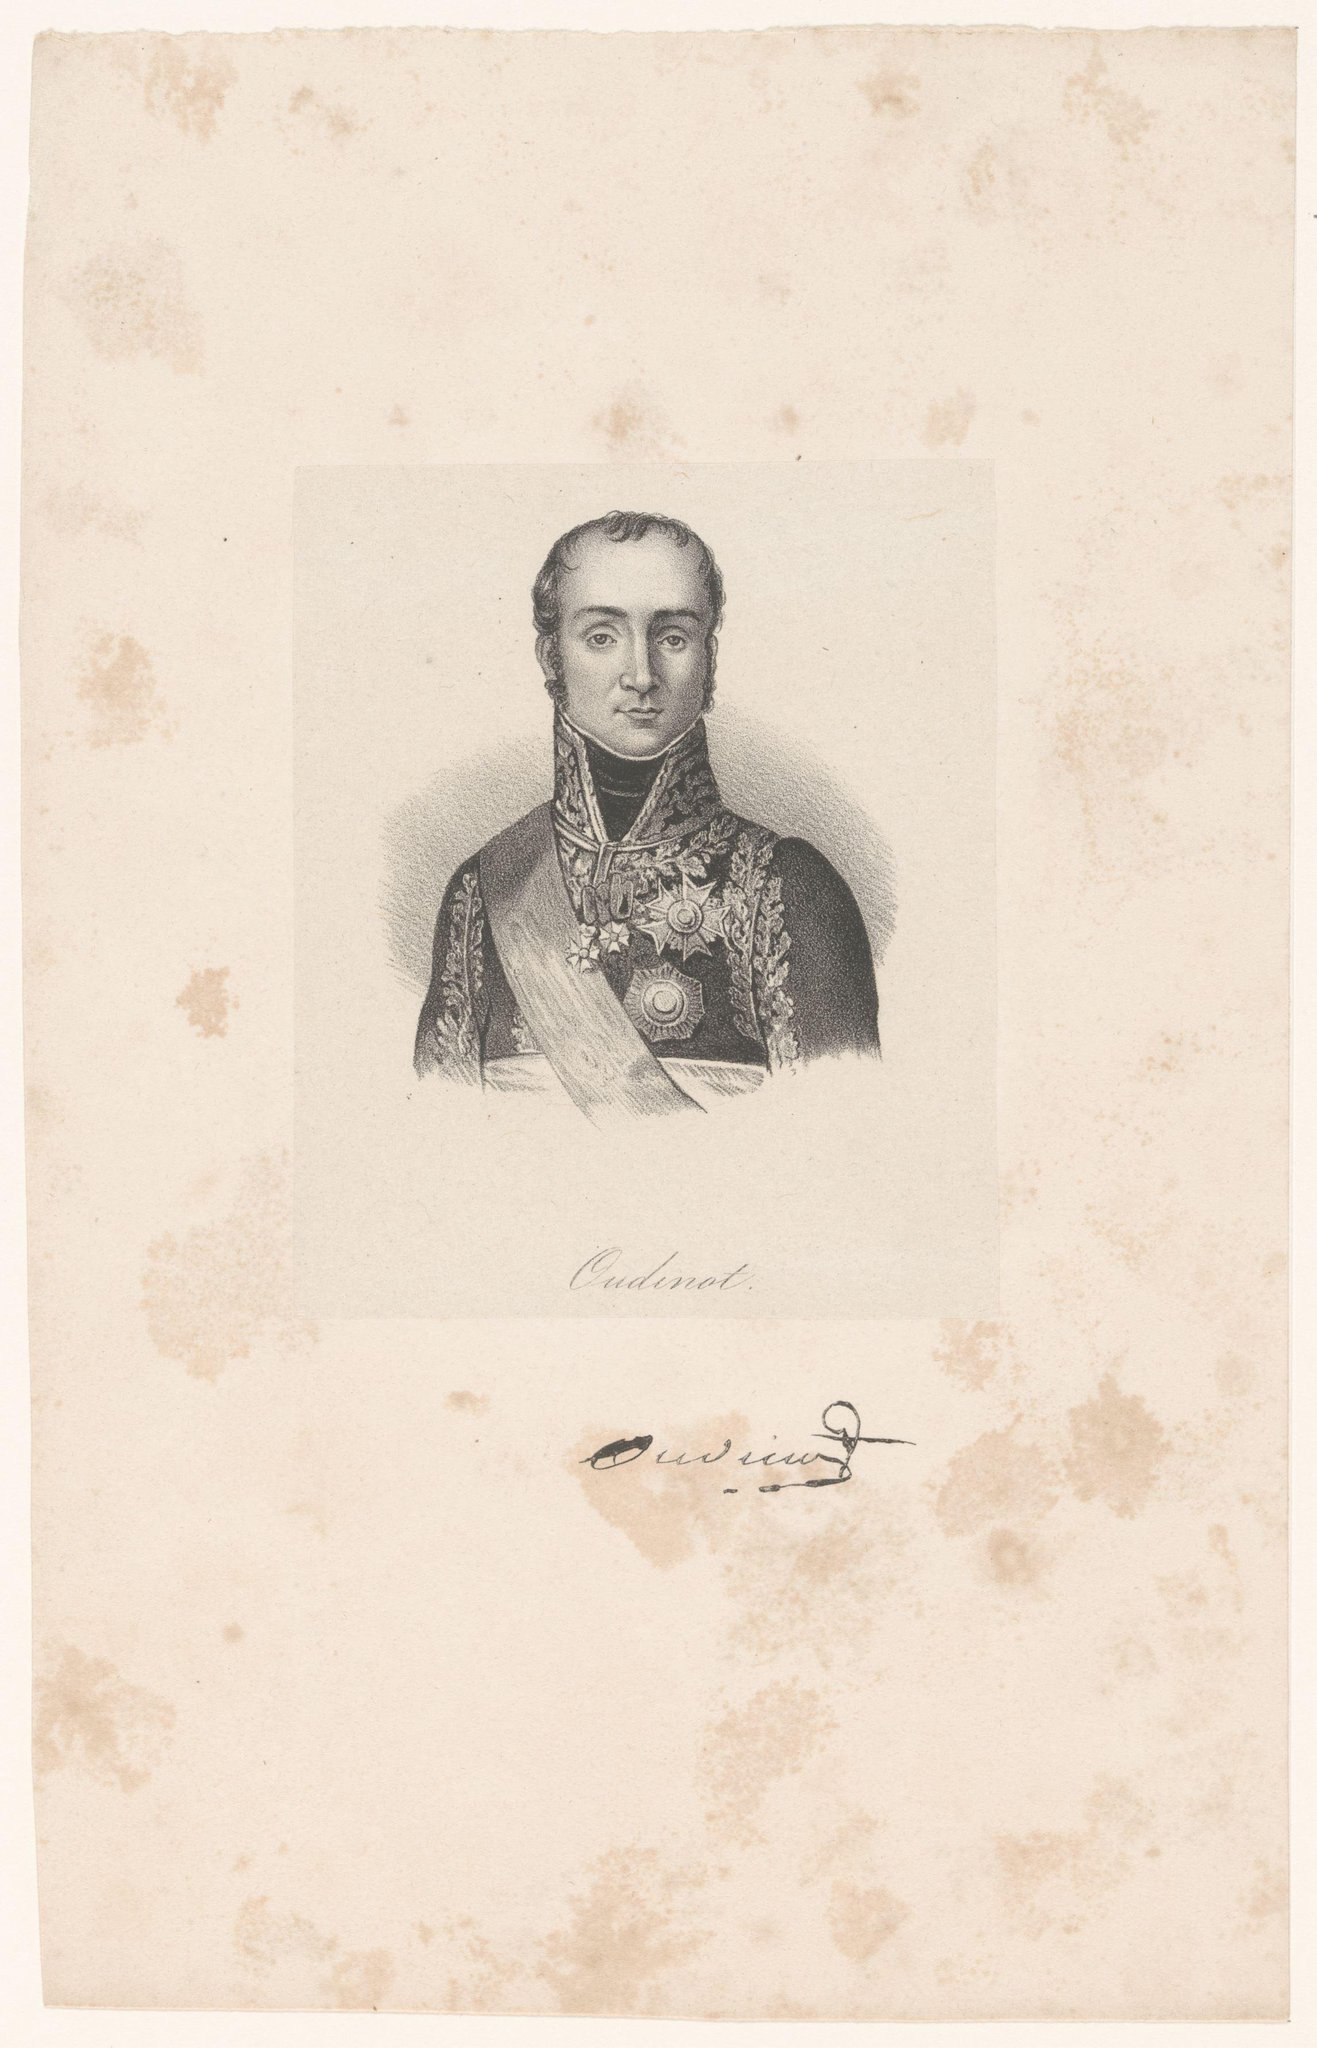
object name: print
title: Oudinot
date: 1818-1842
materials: paper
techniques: lithograph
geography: paris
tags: paris, historical persons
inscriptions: collector's mark: Lugt 2228a